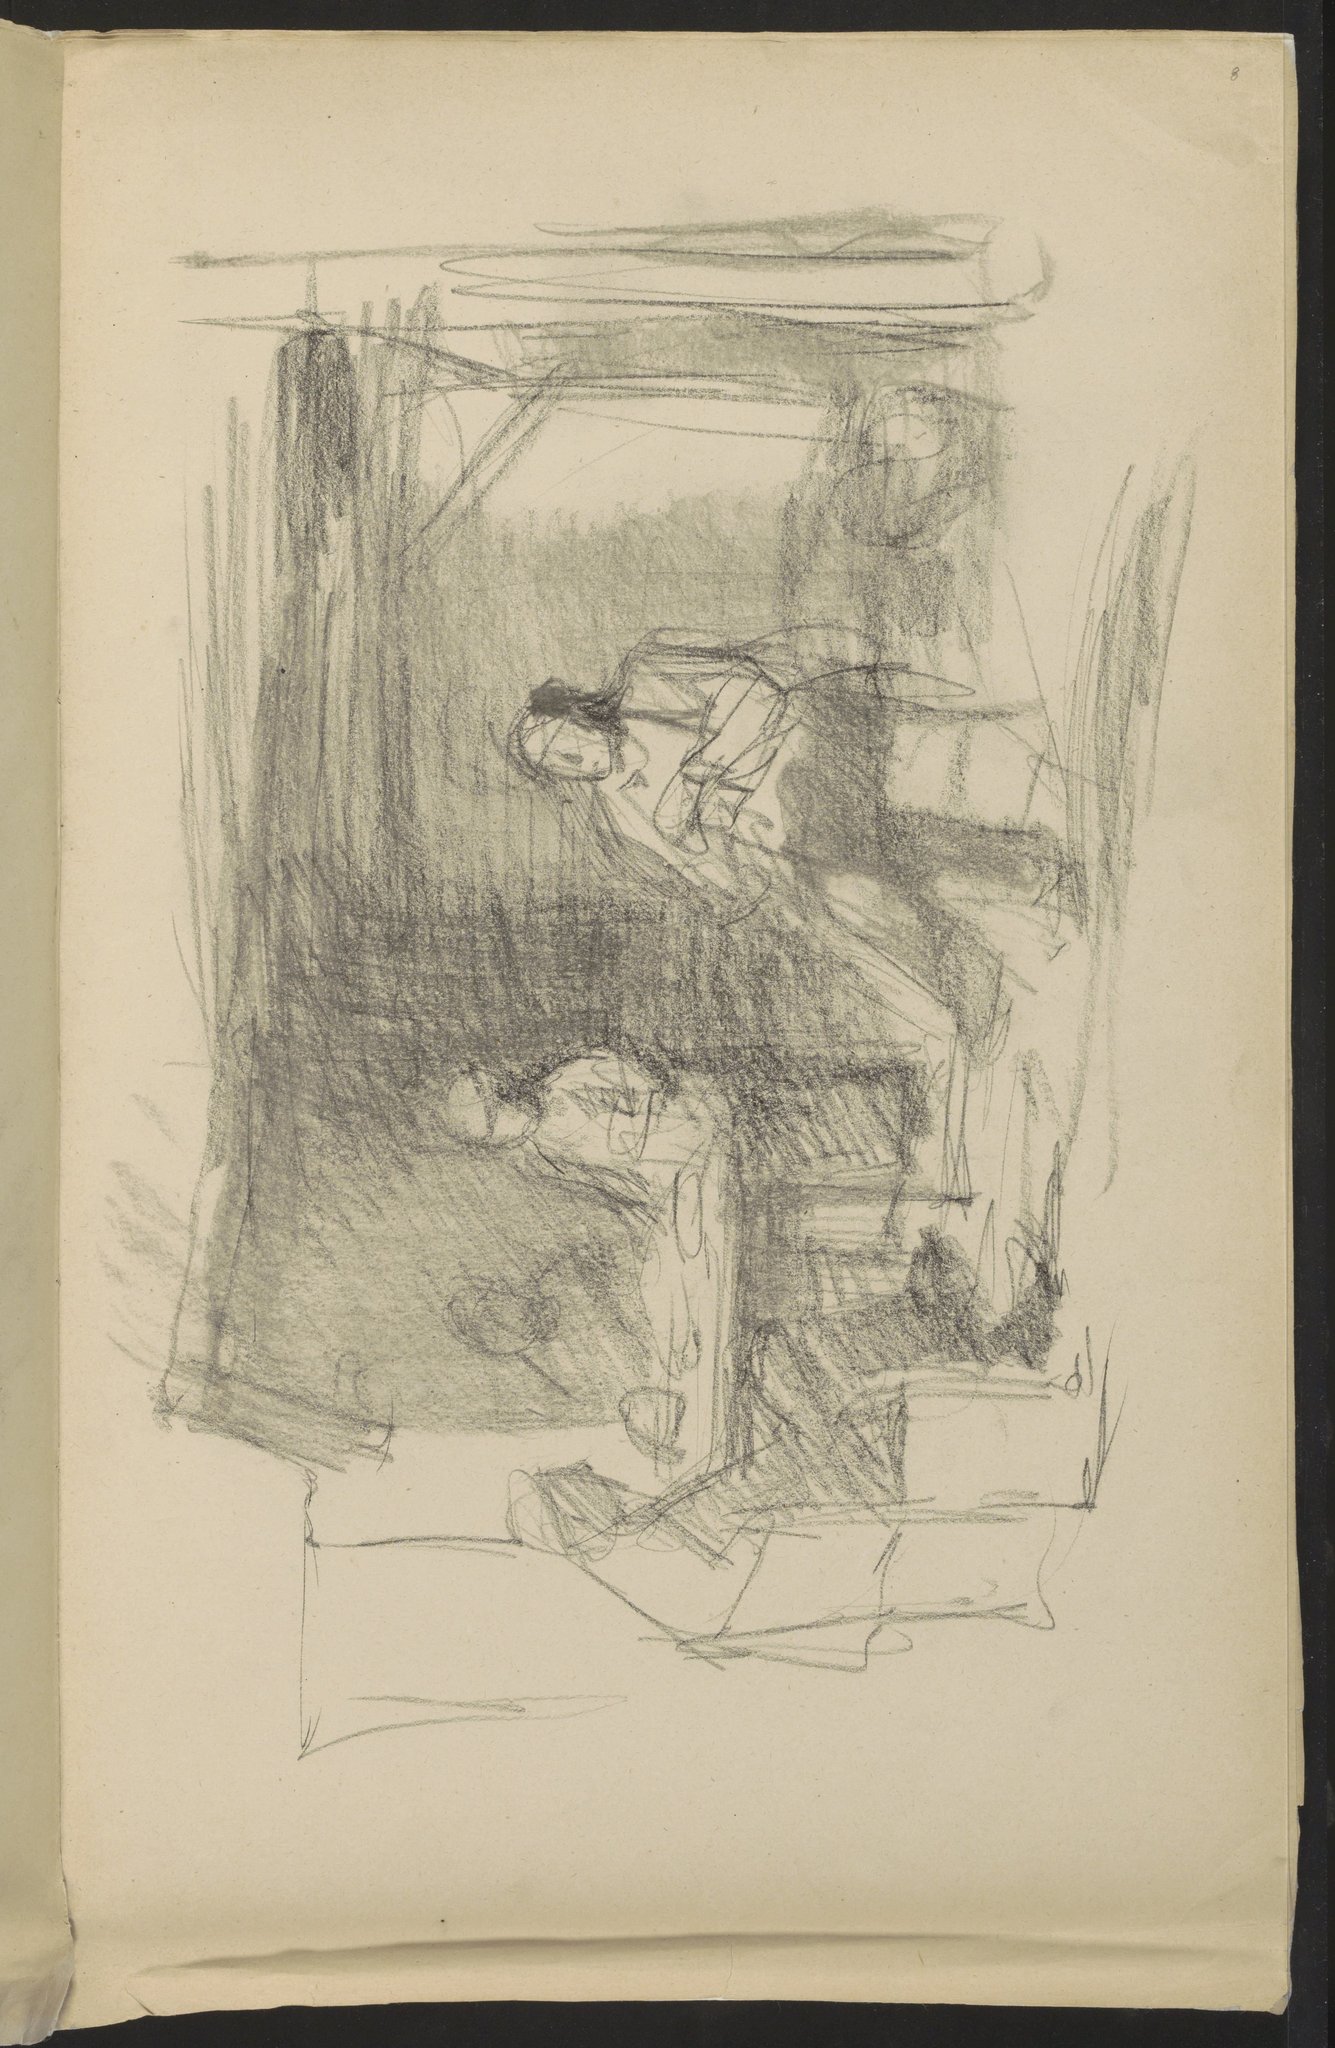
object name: sketchbook leaf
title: Interieur met vier figuren rondom een tafel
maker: albert neuhuys (1844-1914)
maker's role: draughtsman, painter, print maker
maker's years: 1844-1914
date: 1854-1914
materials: chalk, paper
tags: sitting figure, table, interior of the house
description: Blad 8 recto uit een schetsboek met 53 bladen.